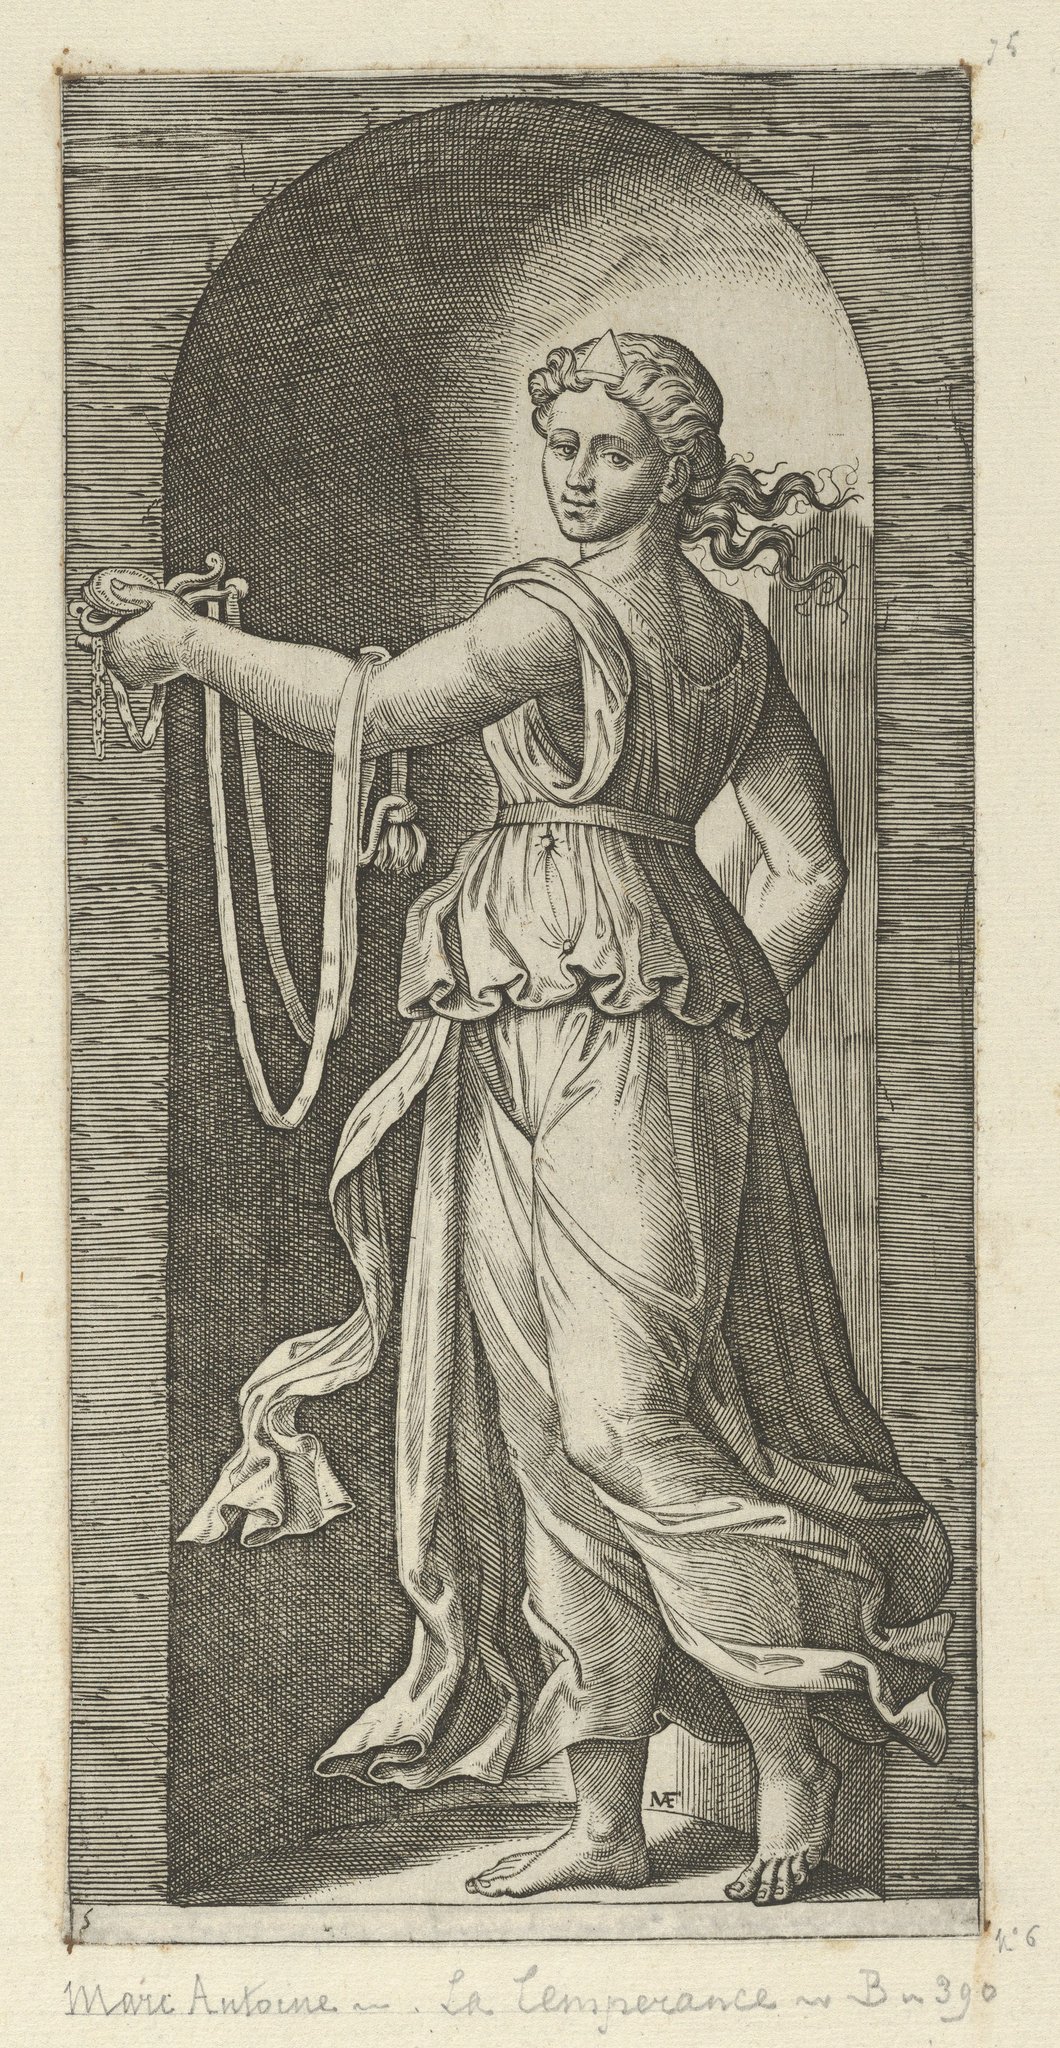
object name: print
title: Temperance personfied by a woman standing in a niche holding a bit, from "The Virtues"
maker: marcantonio raimondi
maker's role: artist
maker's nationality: italian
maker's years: 1475-1534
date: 1515-1525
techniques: engraving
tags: women